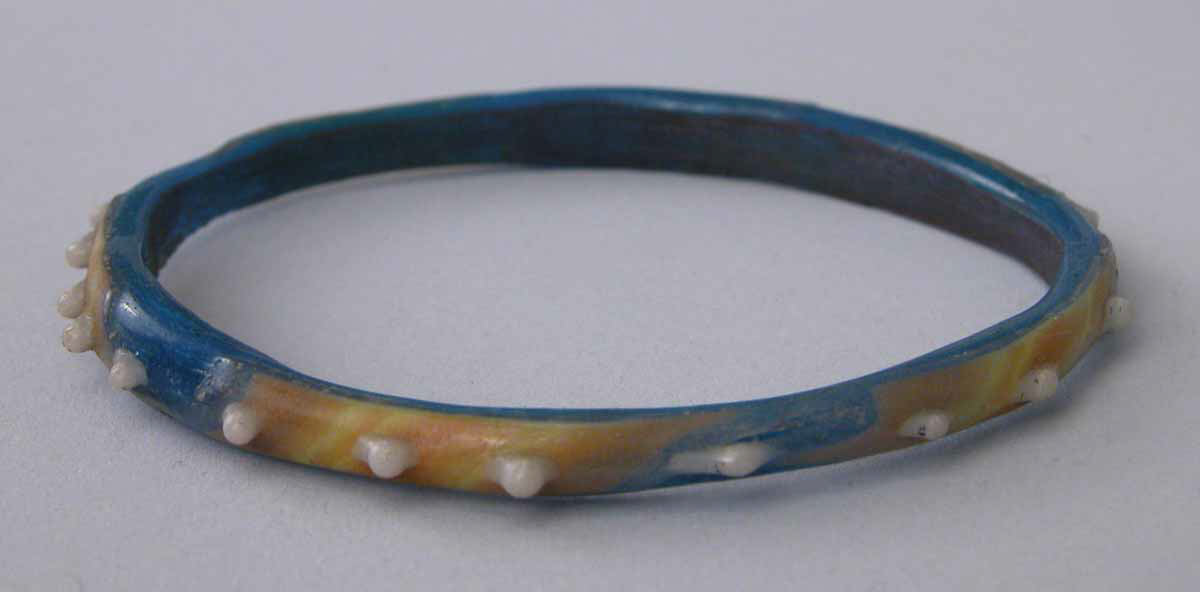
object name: bracelet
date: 1301-1500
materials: glass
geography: egypt or syria